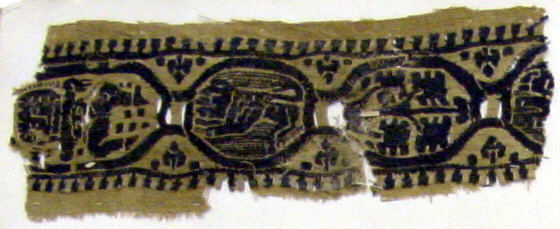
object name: textile fragment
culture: coptic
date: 501-600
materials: linen, wool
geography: egypt